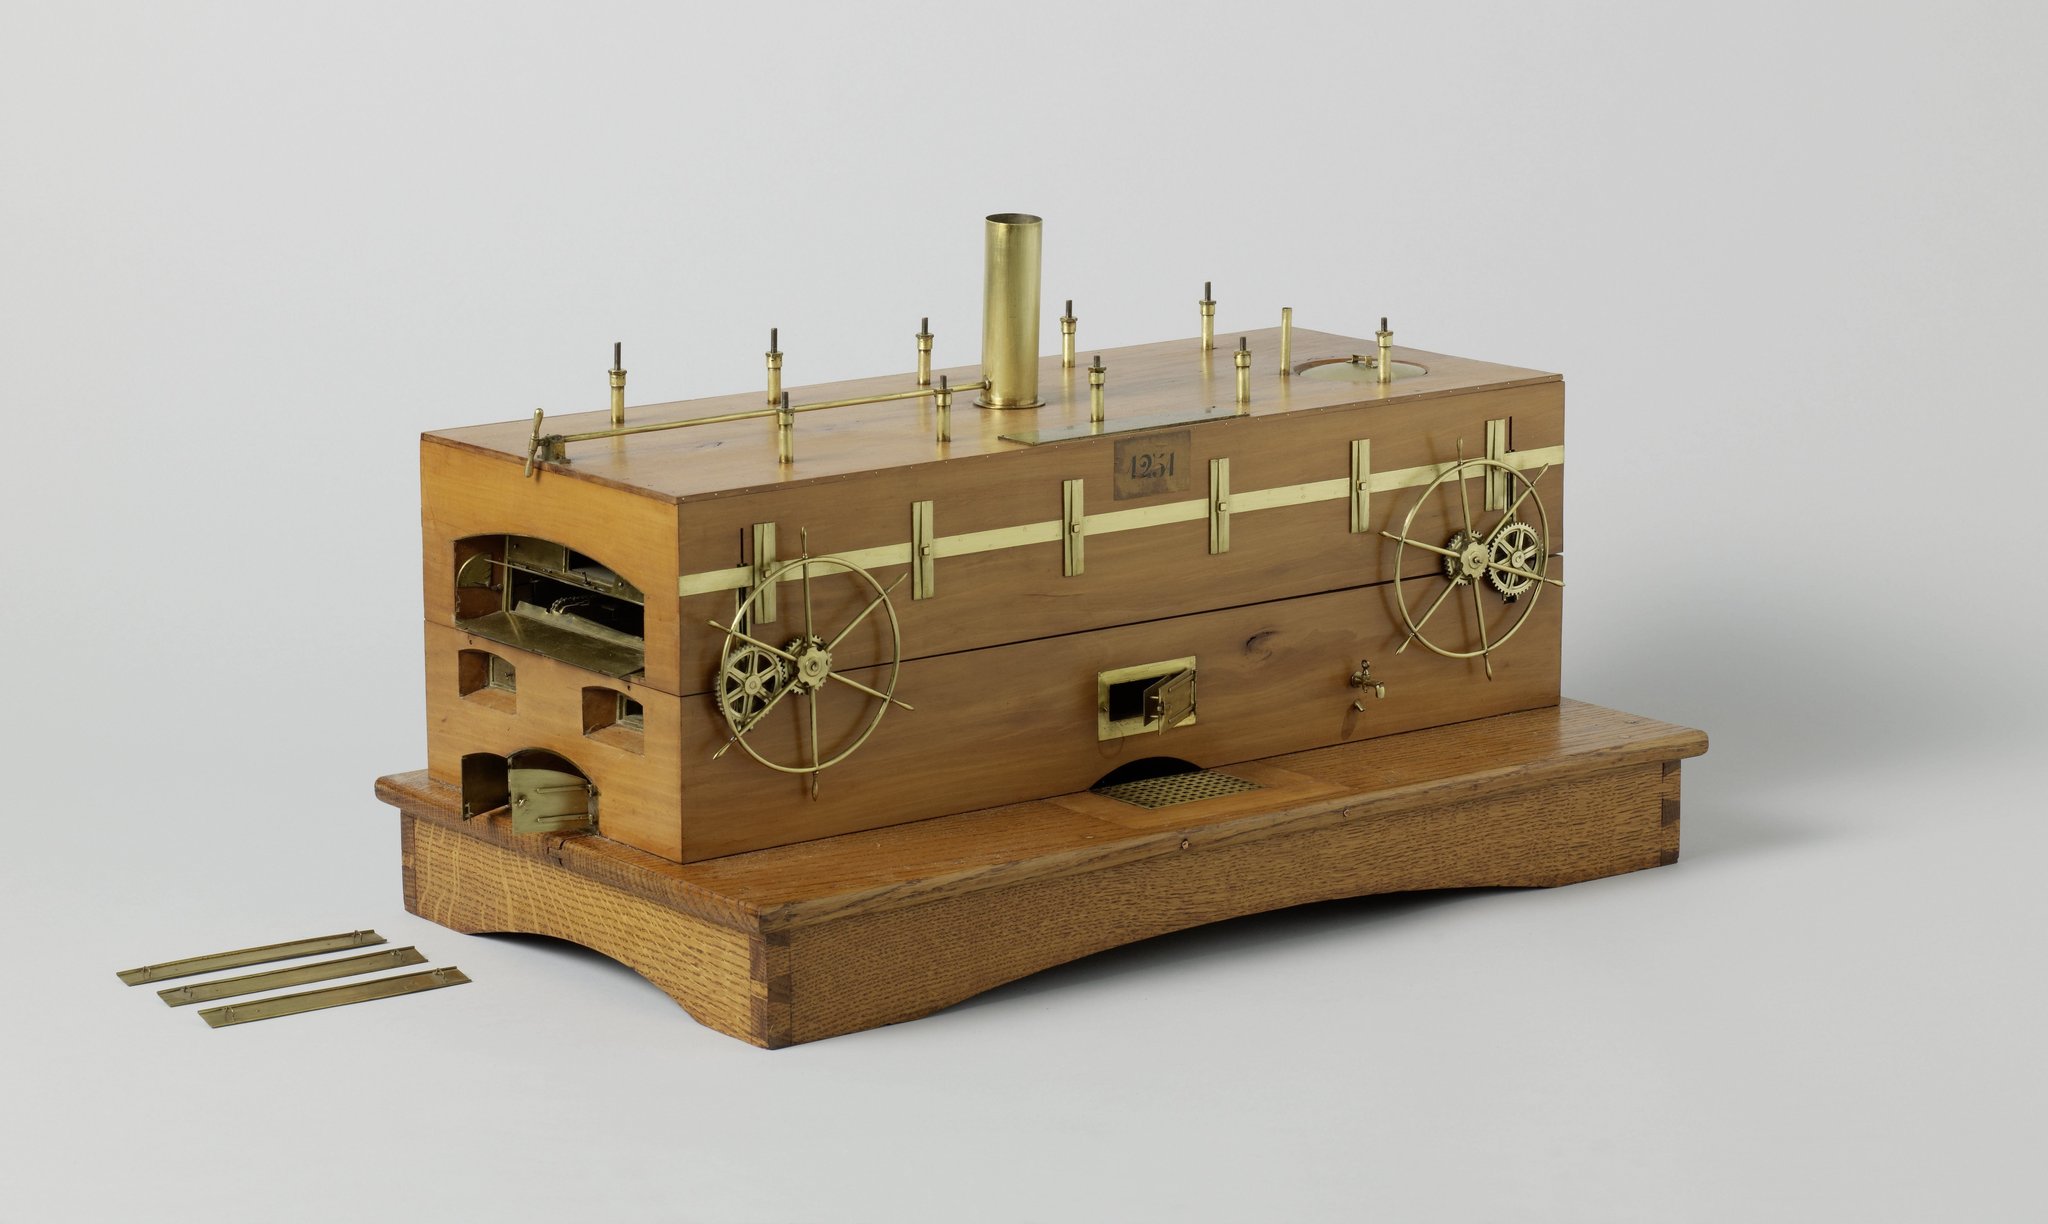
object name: demonstration model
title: Model of a Bread Oven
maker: Anonymous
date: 1860-1870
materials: brass, wood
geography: netherlands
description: Deze machinale bakoven werd door de Marine gebruikt op haar basis van het Nieuwendiep, en werd ook kettingoven genoemd.